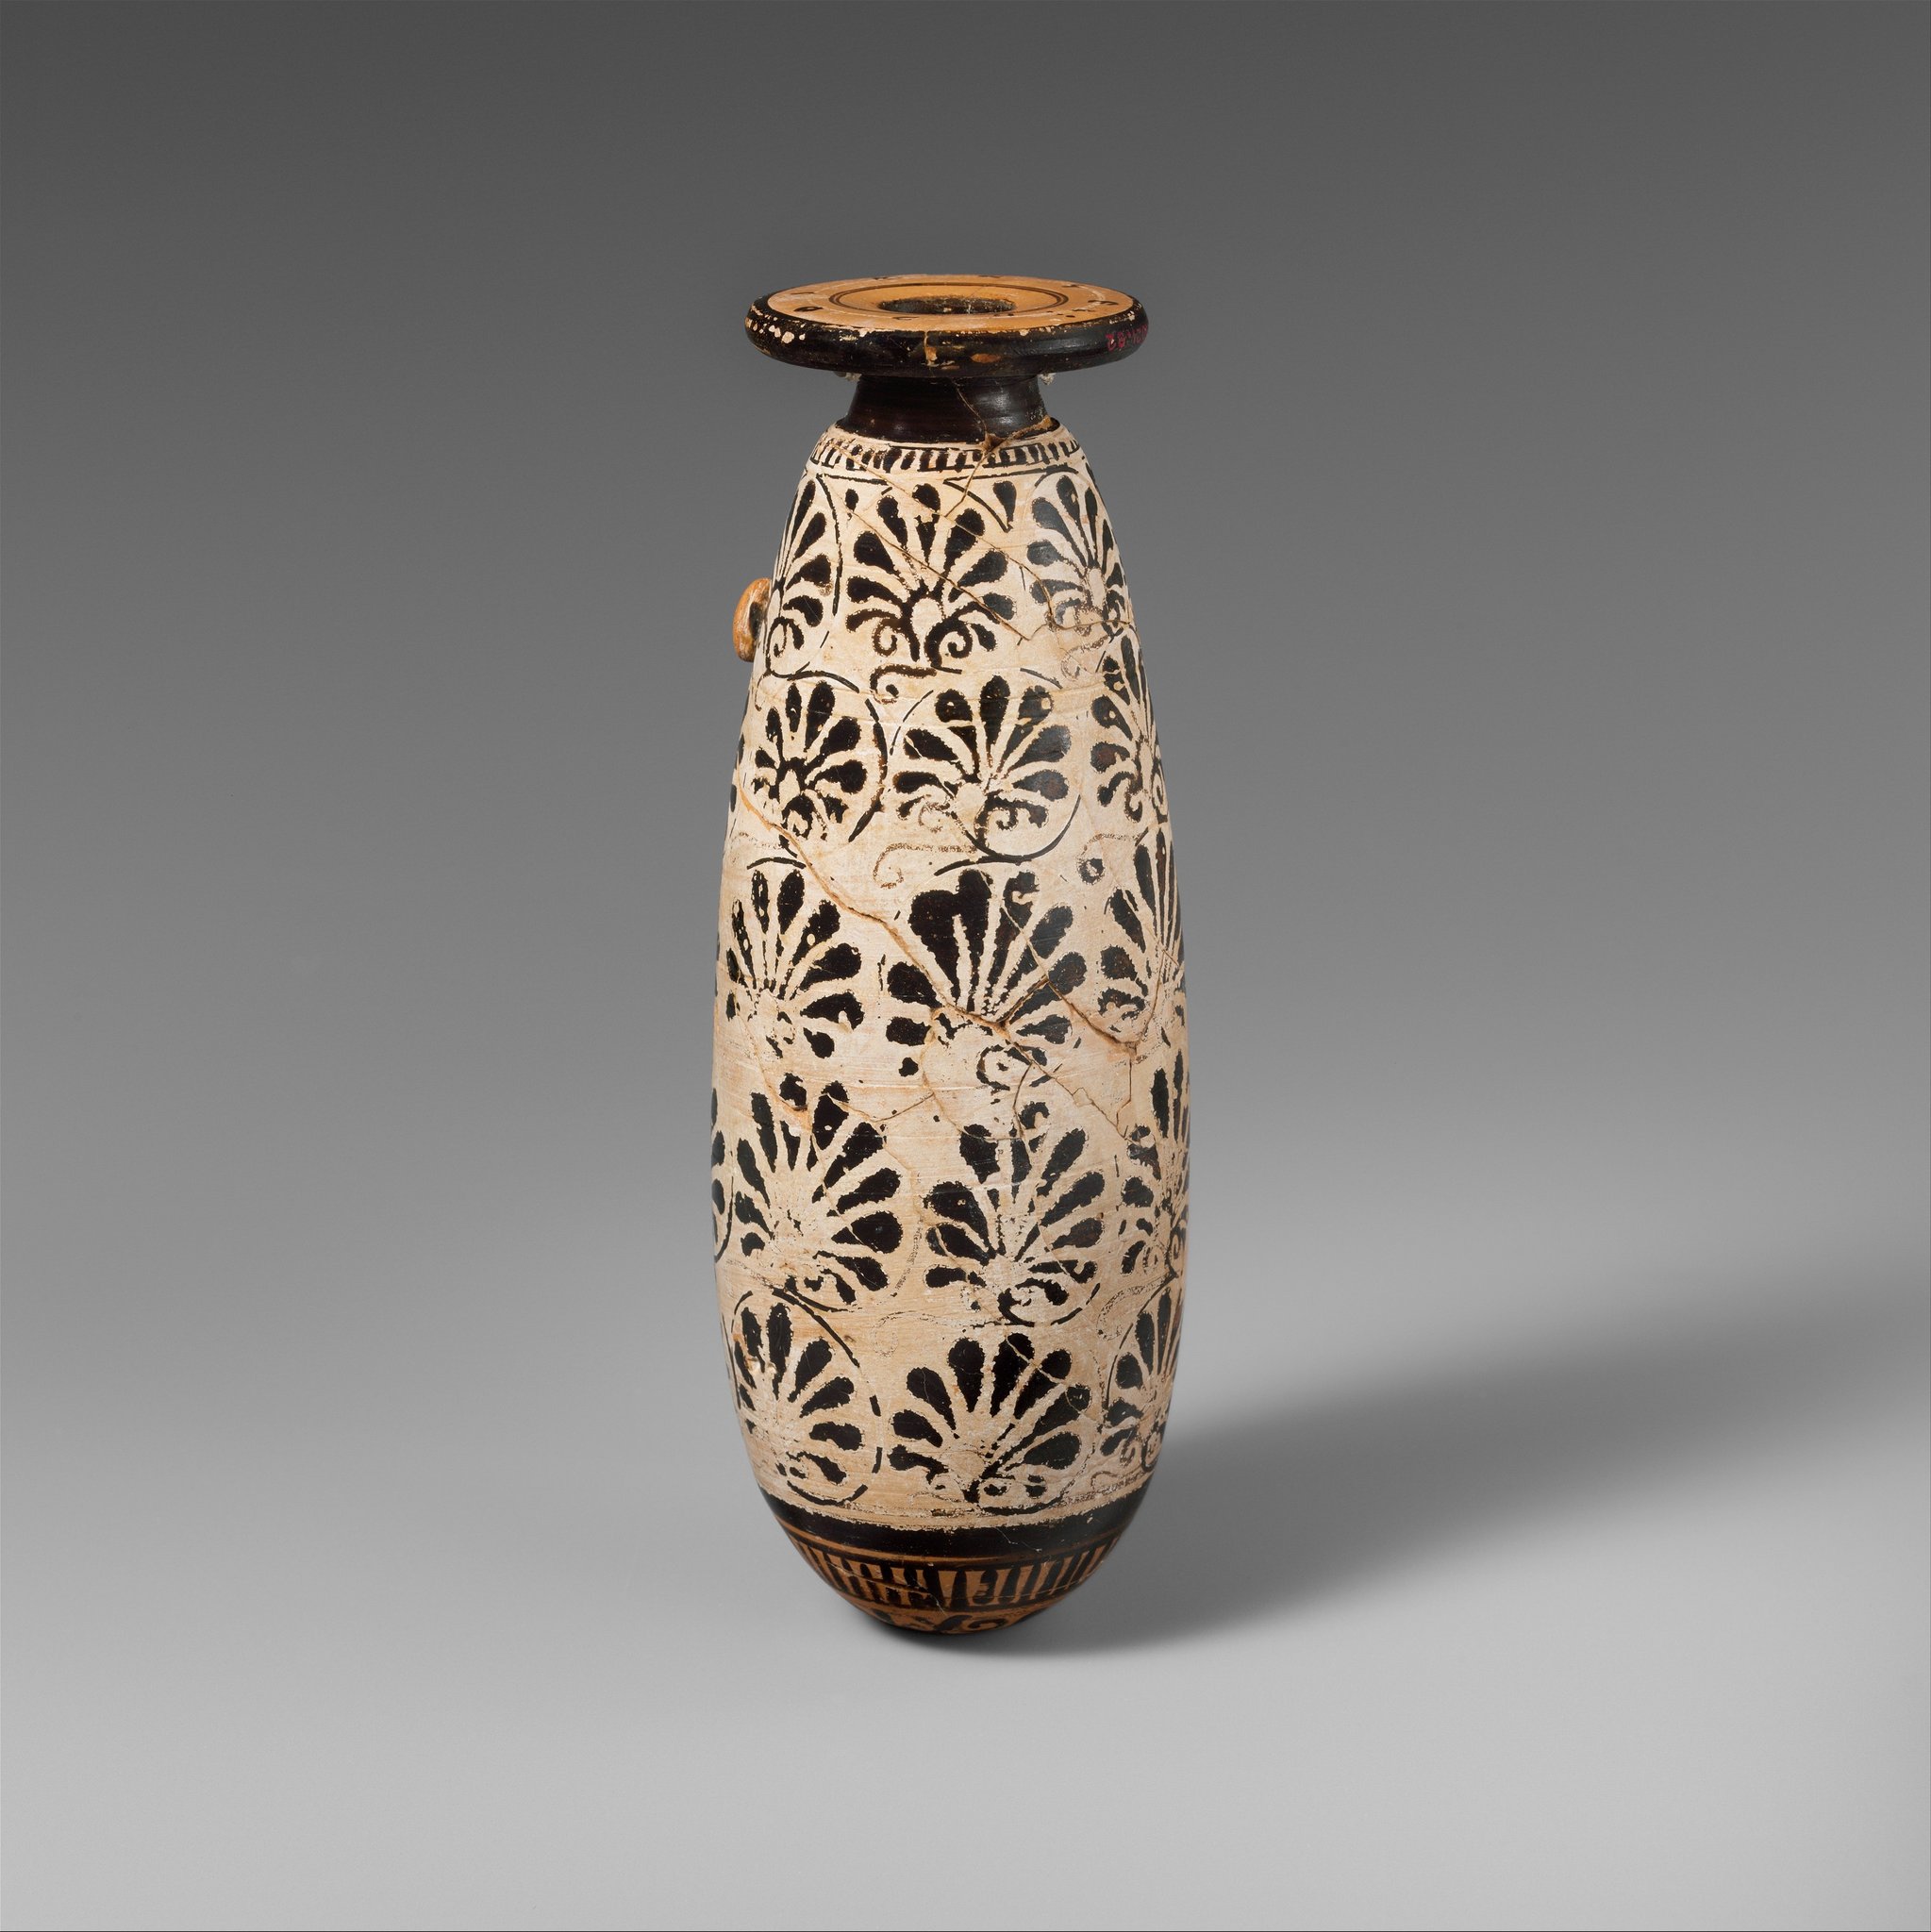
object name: alabastron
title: Terracotta alabastron (perfume vase)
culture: greek, attic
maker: group of the paidikos alabastra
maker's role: artist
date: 510-500 BCE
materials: terracotta